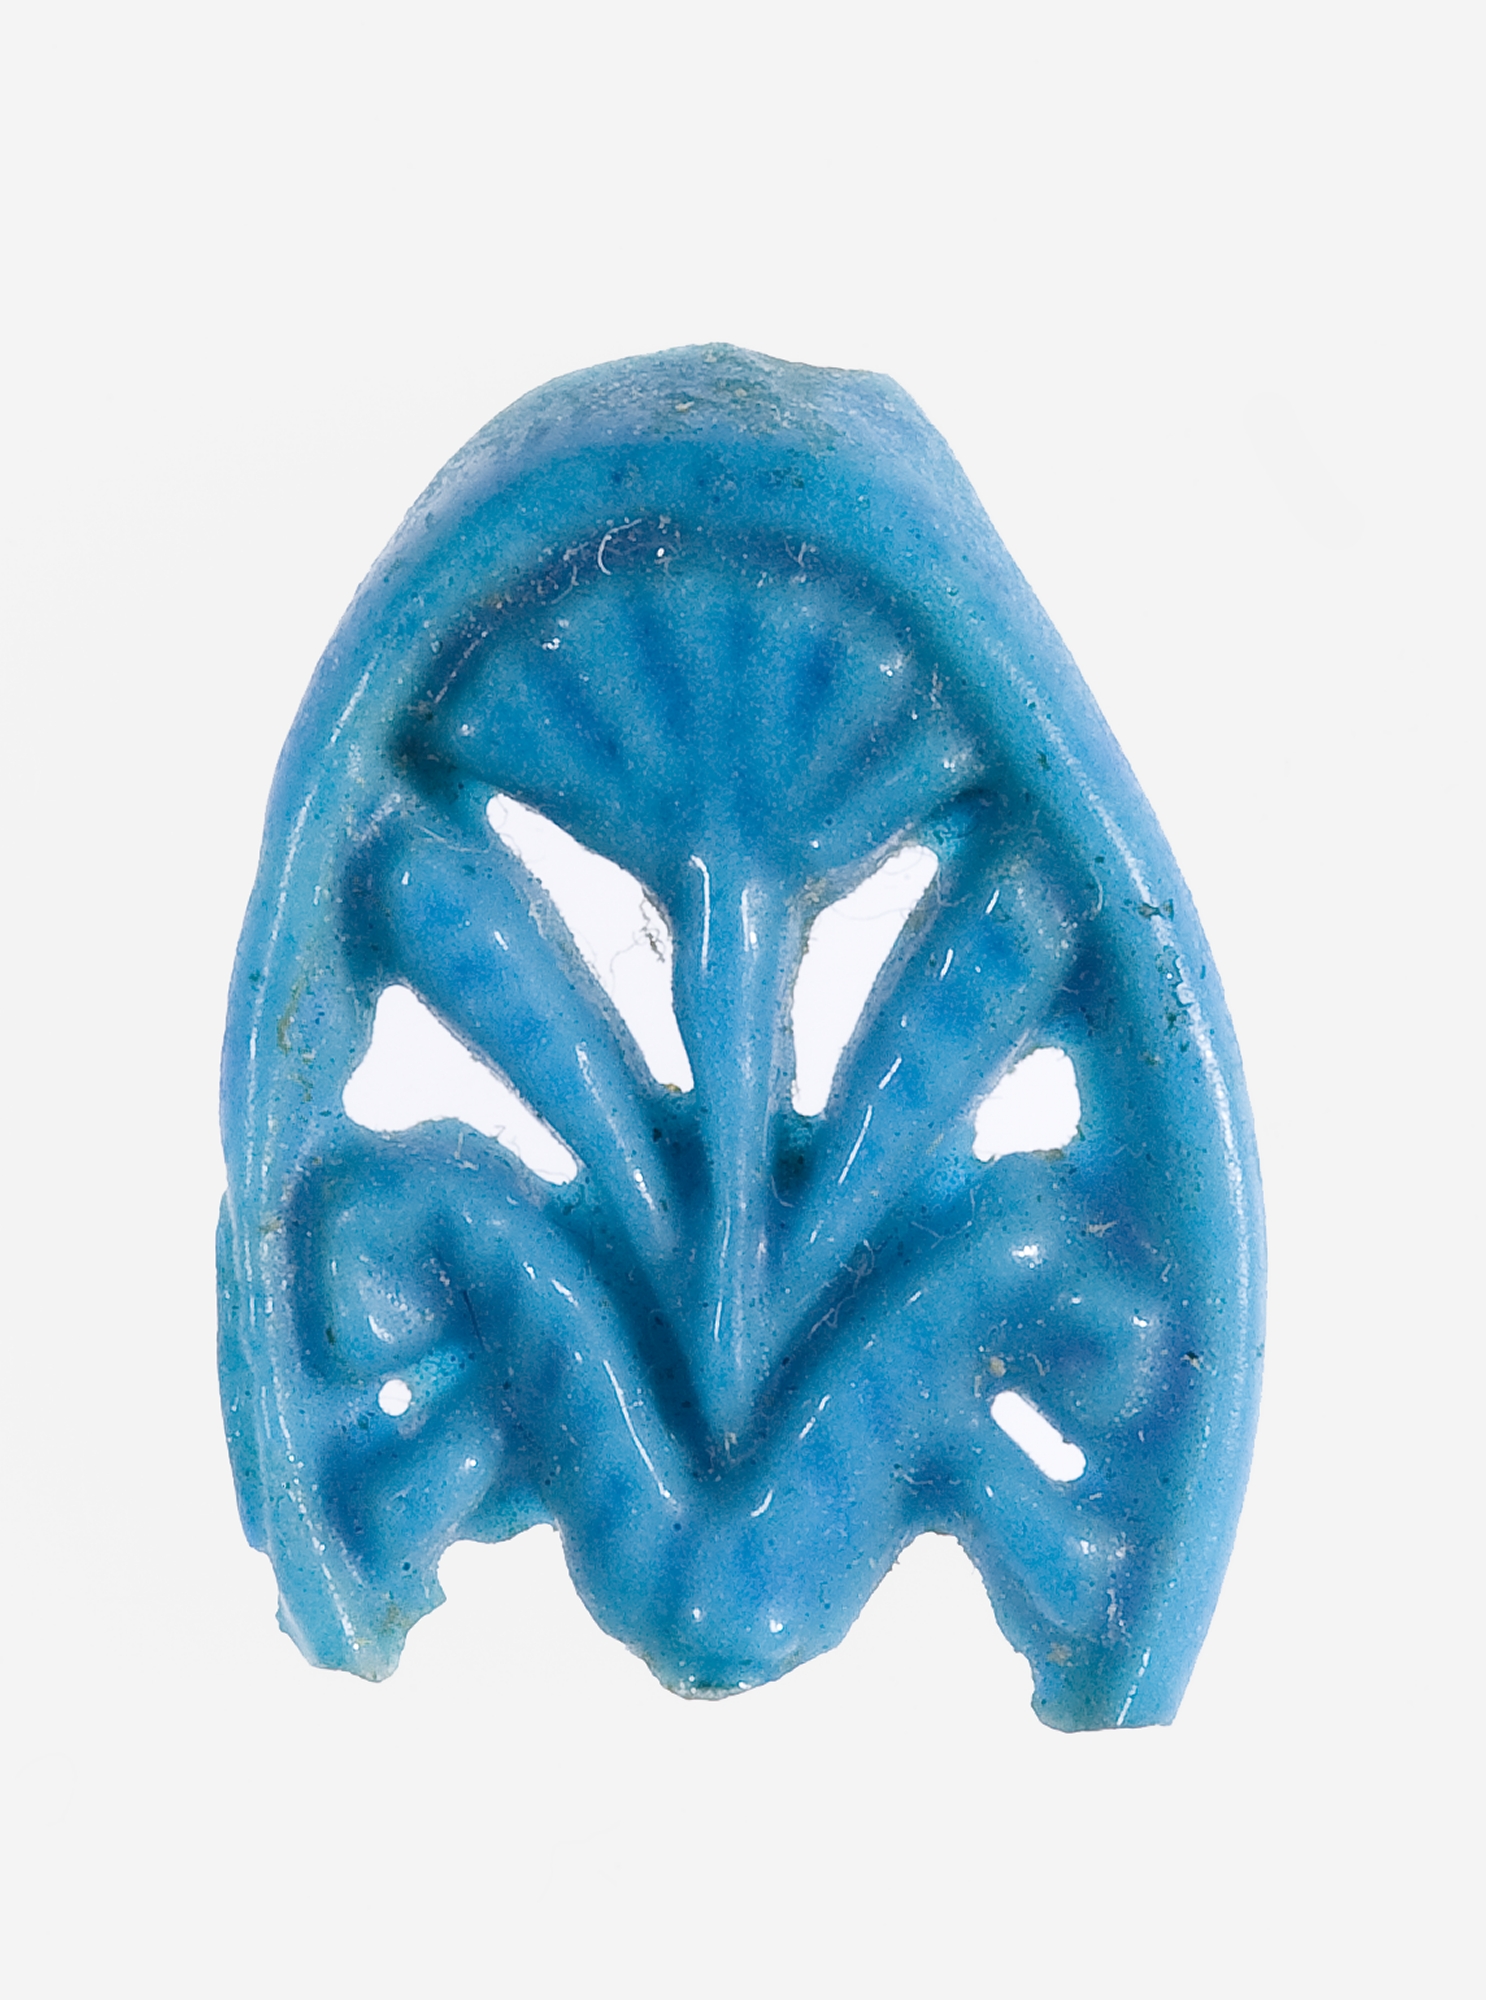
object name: ring, floral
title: Ring Fragment Decorated with a Floral Design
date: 1390-1352 BCE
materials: faience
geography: egypt